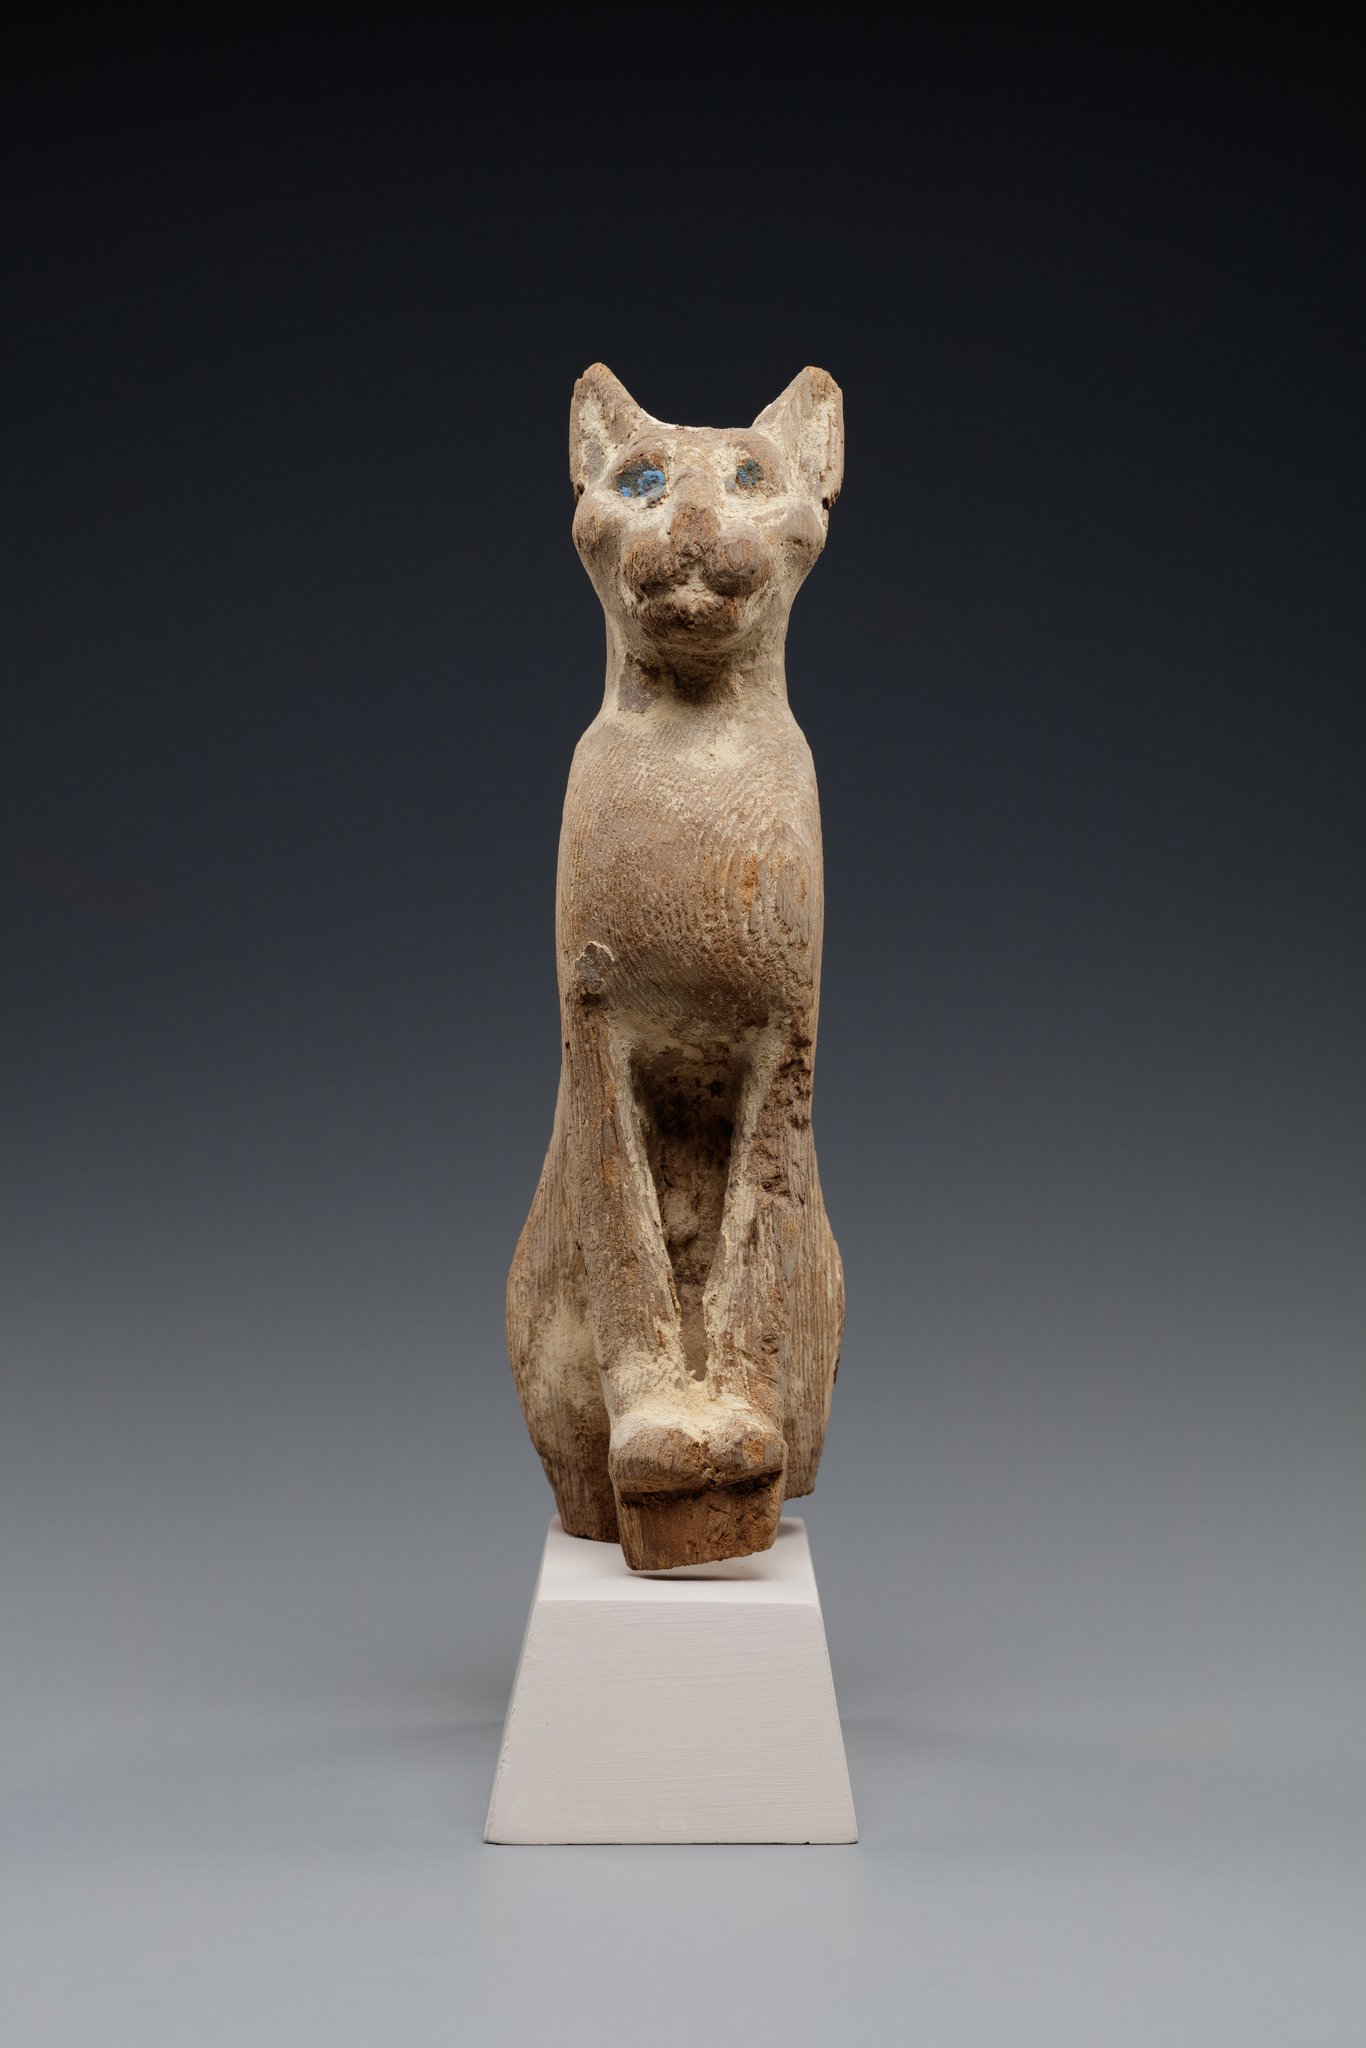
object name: figurine, cat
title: Statuette of a cat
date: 664-332 BCE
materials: wood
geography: egypt